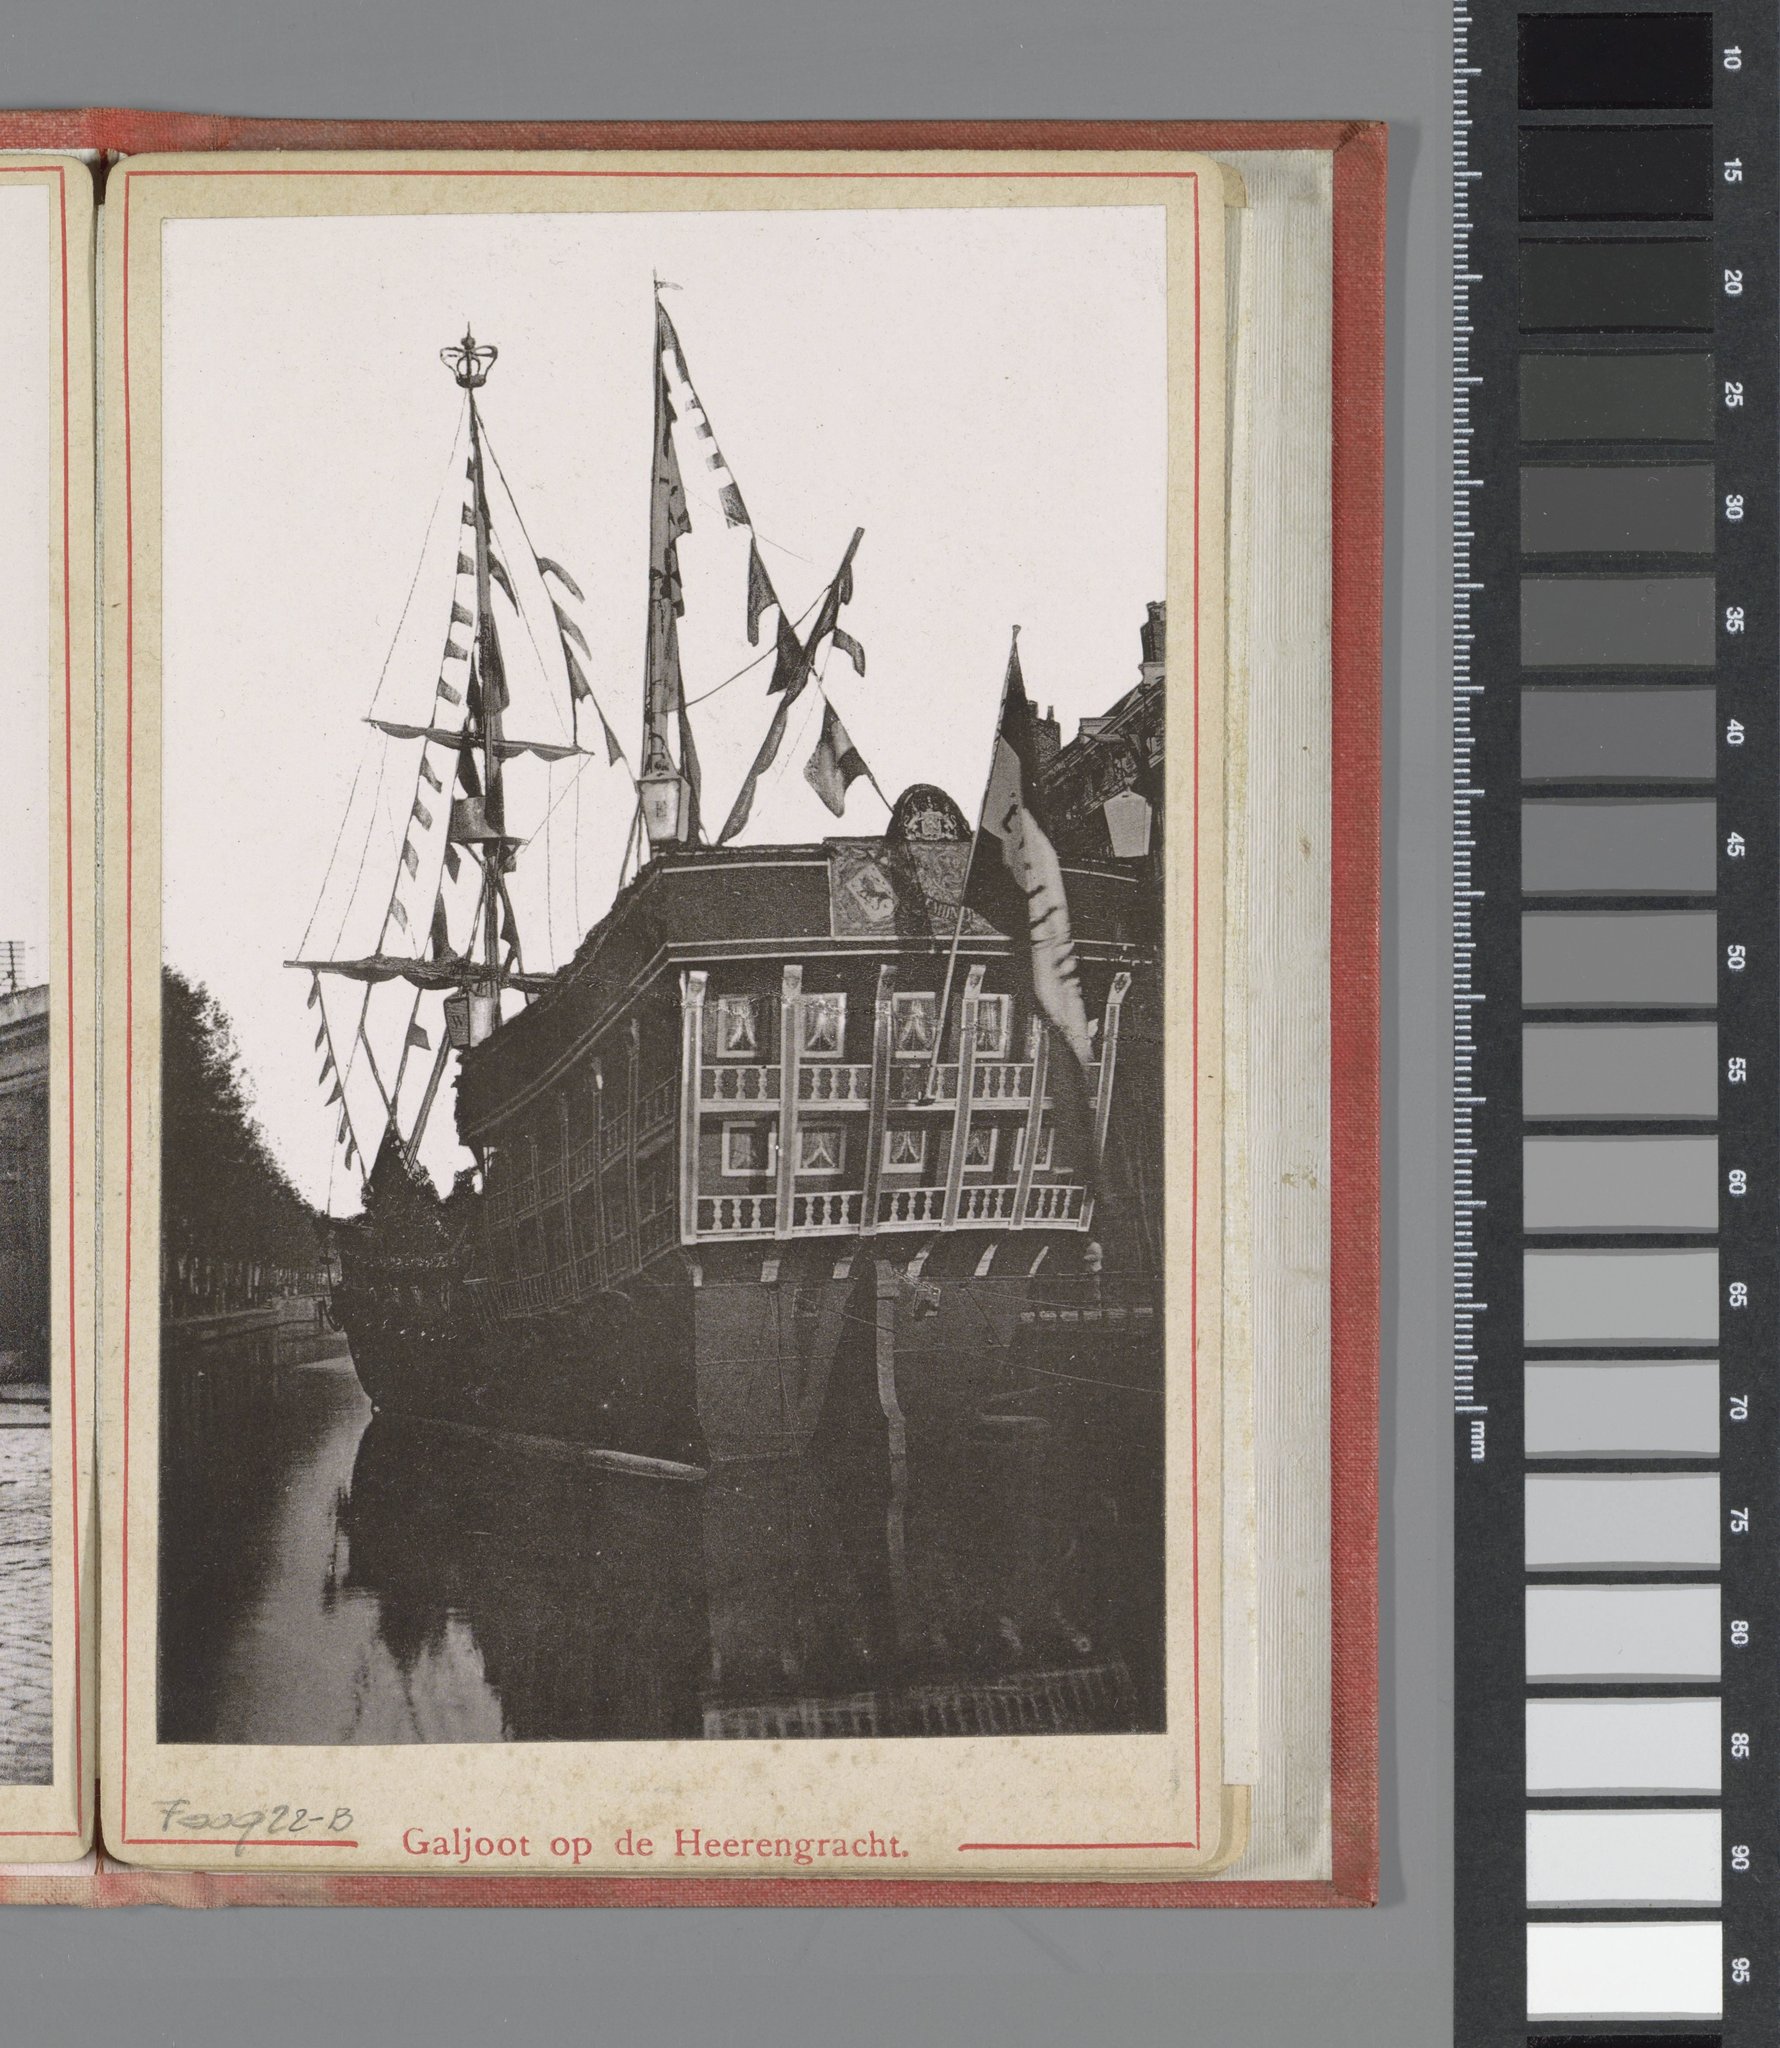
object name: photograph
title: Replica van een galjoot in de Herengracht tijdens de Aprilfeesten in 1887 te Amsterdam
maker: Anonymous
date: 1804-1887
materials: cardboard, paper, ink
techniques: photograph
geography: amsterdam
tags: sailing-ship, sailing-boat, canal, prospect of city, town panorama, silhouette of city, amsterdam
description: Onderdeel van Fotoalbum met opnames van de Aprilfeesten in 1887 te Amsterdam.